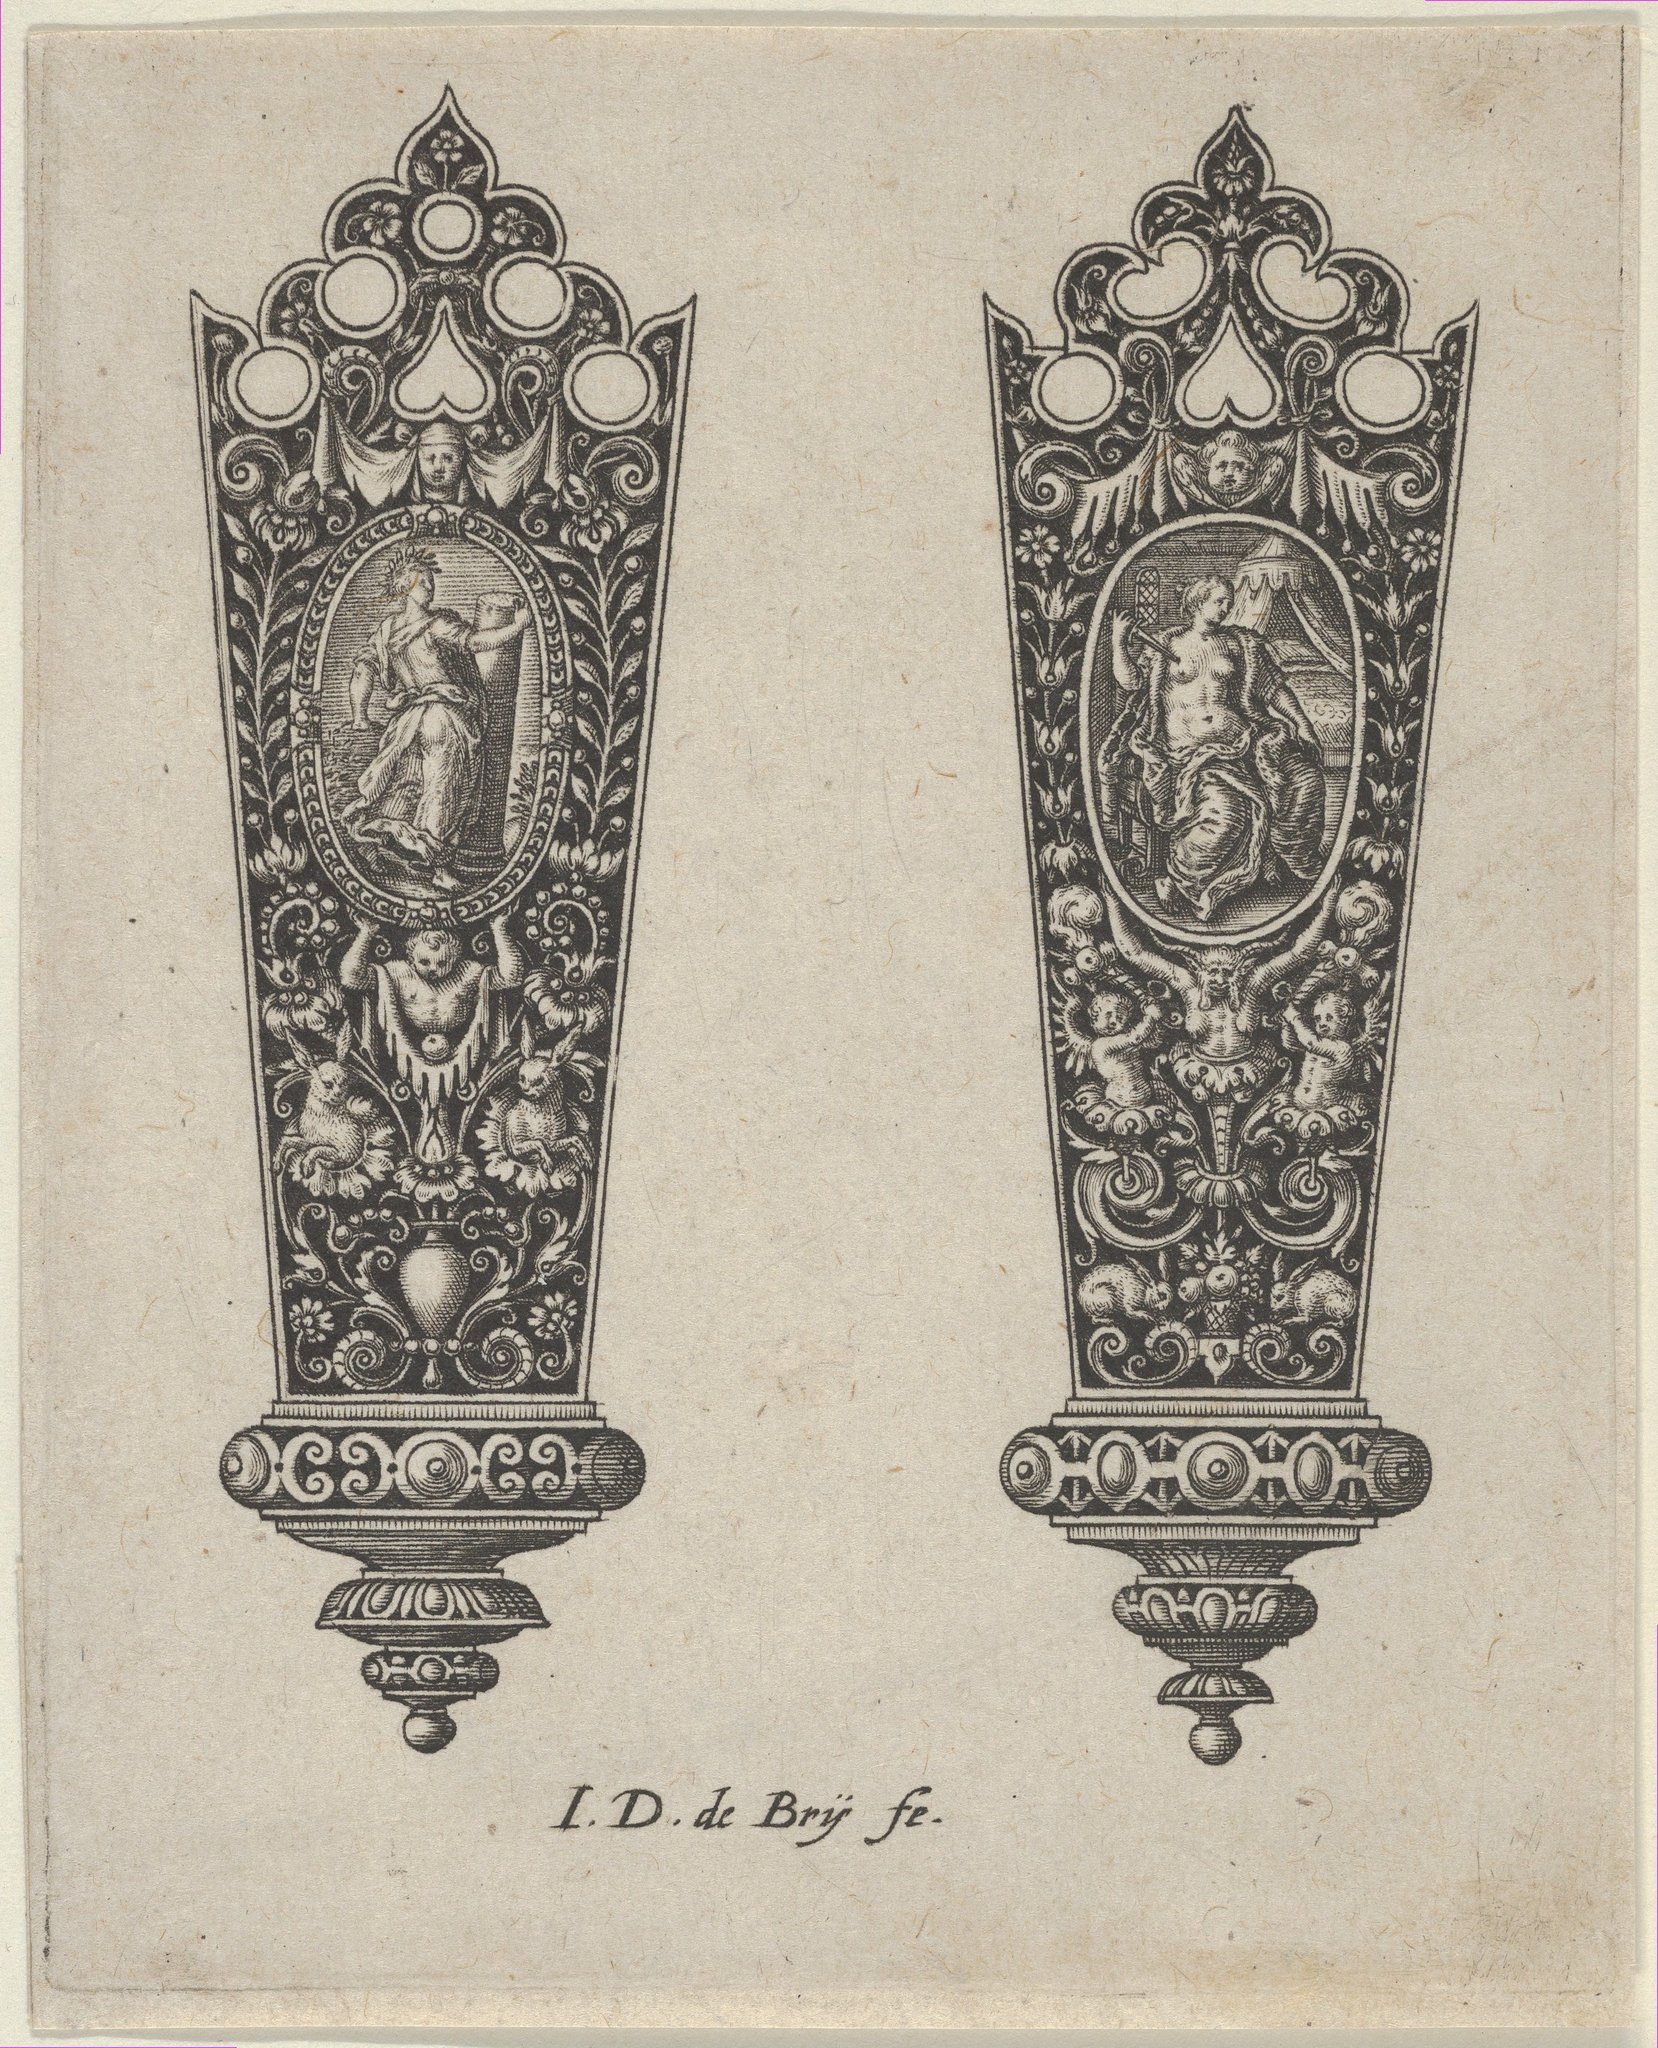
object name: print ornament architecture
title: Design for Knife Handles with Ovals Containing Fortitude and the Death of Lucretia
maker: johann theodor de bry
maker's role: artist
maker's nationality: netherlandish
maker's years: 1561-1623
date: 1580-1600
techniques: embroidery, engraving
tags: hilts,ornament,men,female nudes